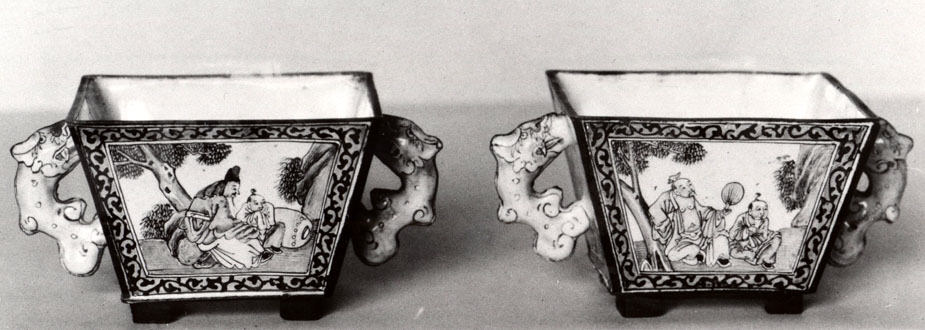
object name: cup with handle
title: Square Cup with Handle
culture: chinese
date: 1801-1900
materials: enamel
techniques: painting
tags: human figures